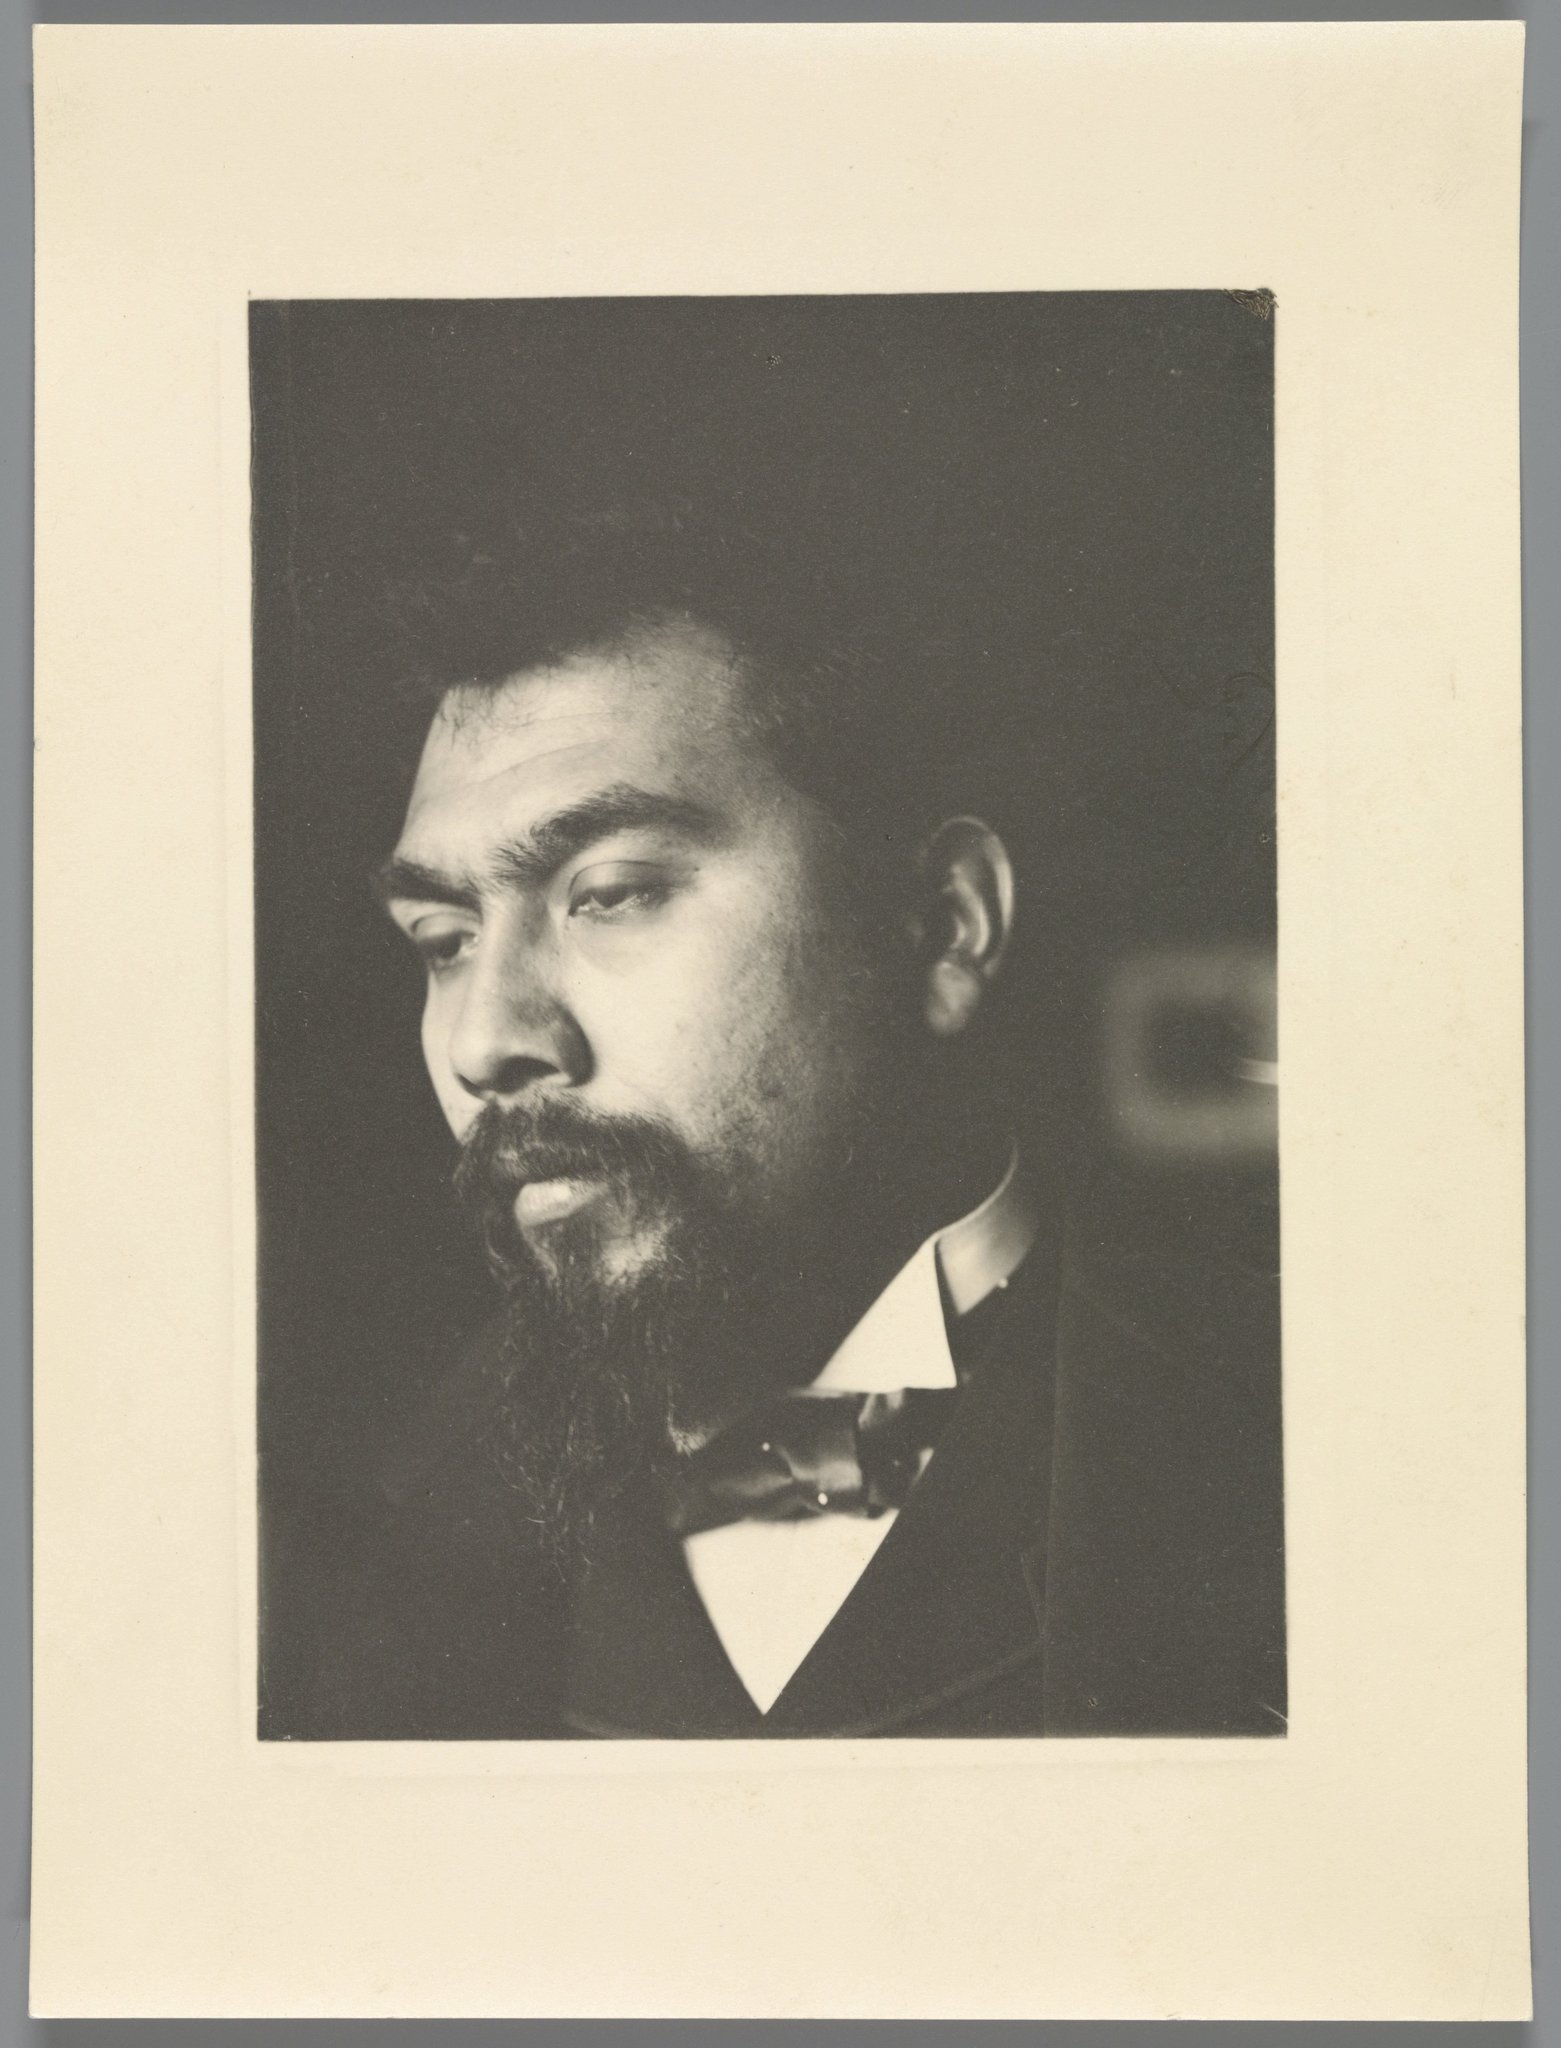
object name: photograph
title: Reproductie naar een foto van Willem Witsen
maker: Anonymous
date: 1860-1915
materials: paper, photographic support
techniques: gelatin silver print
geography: netherlands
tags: the hague, painter, print maker, draughtsman, jan toorop